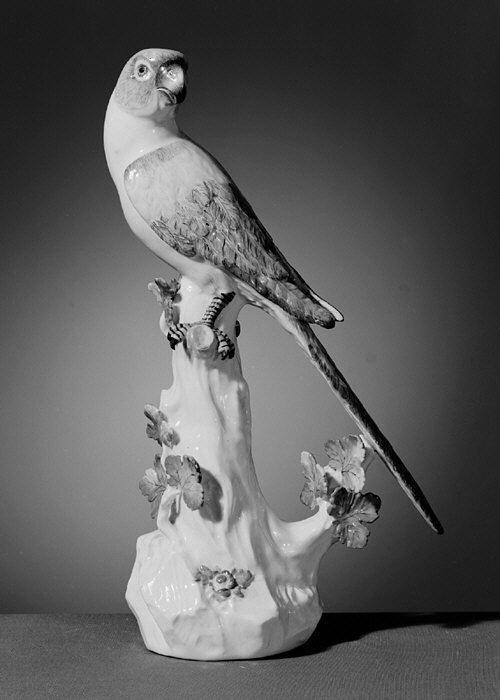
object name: figure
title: Parakeet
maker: meissen manufactory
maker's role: manufactory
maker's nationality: german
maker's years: 1710-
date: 1741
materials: hard paste porcelain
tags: birds,leaves